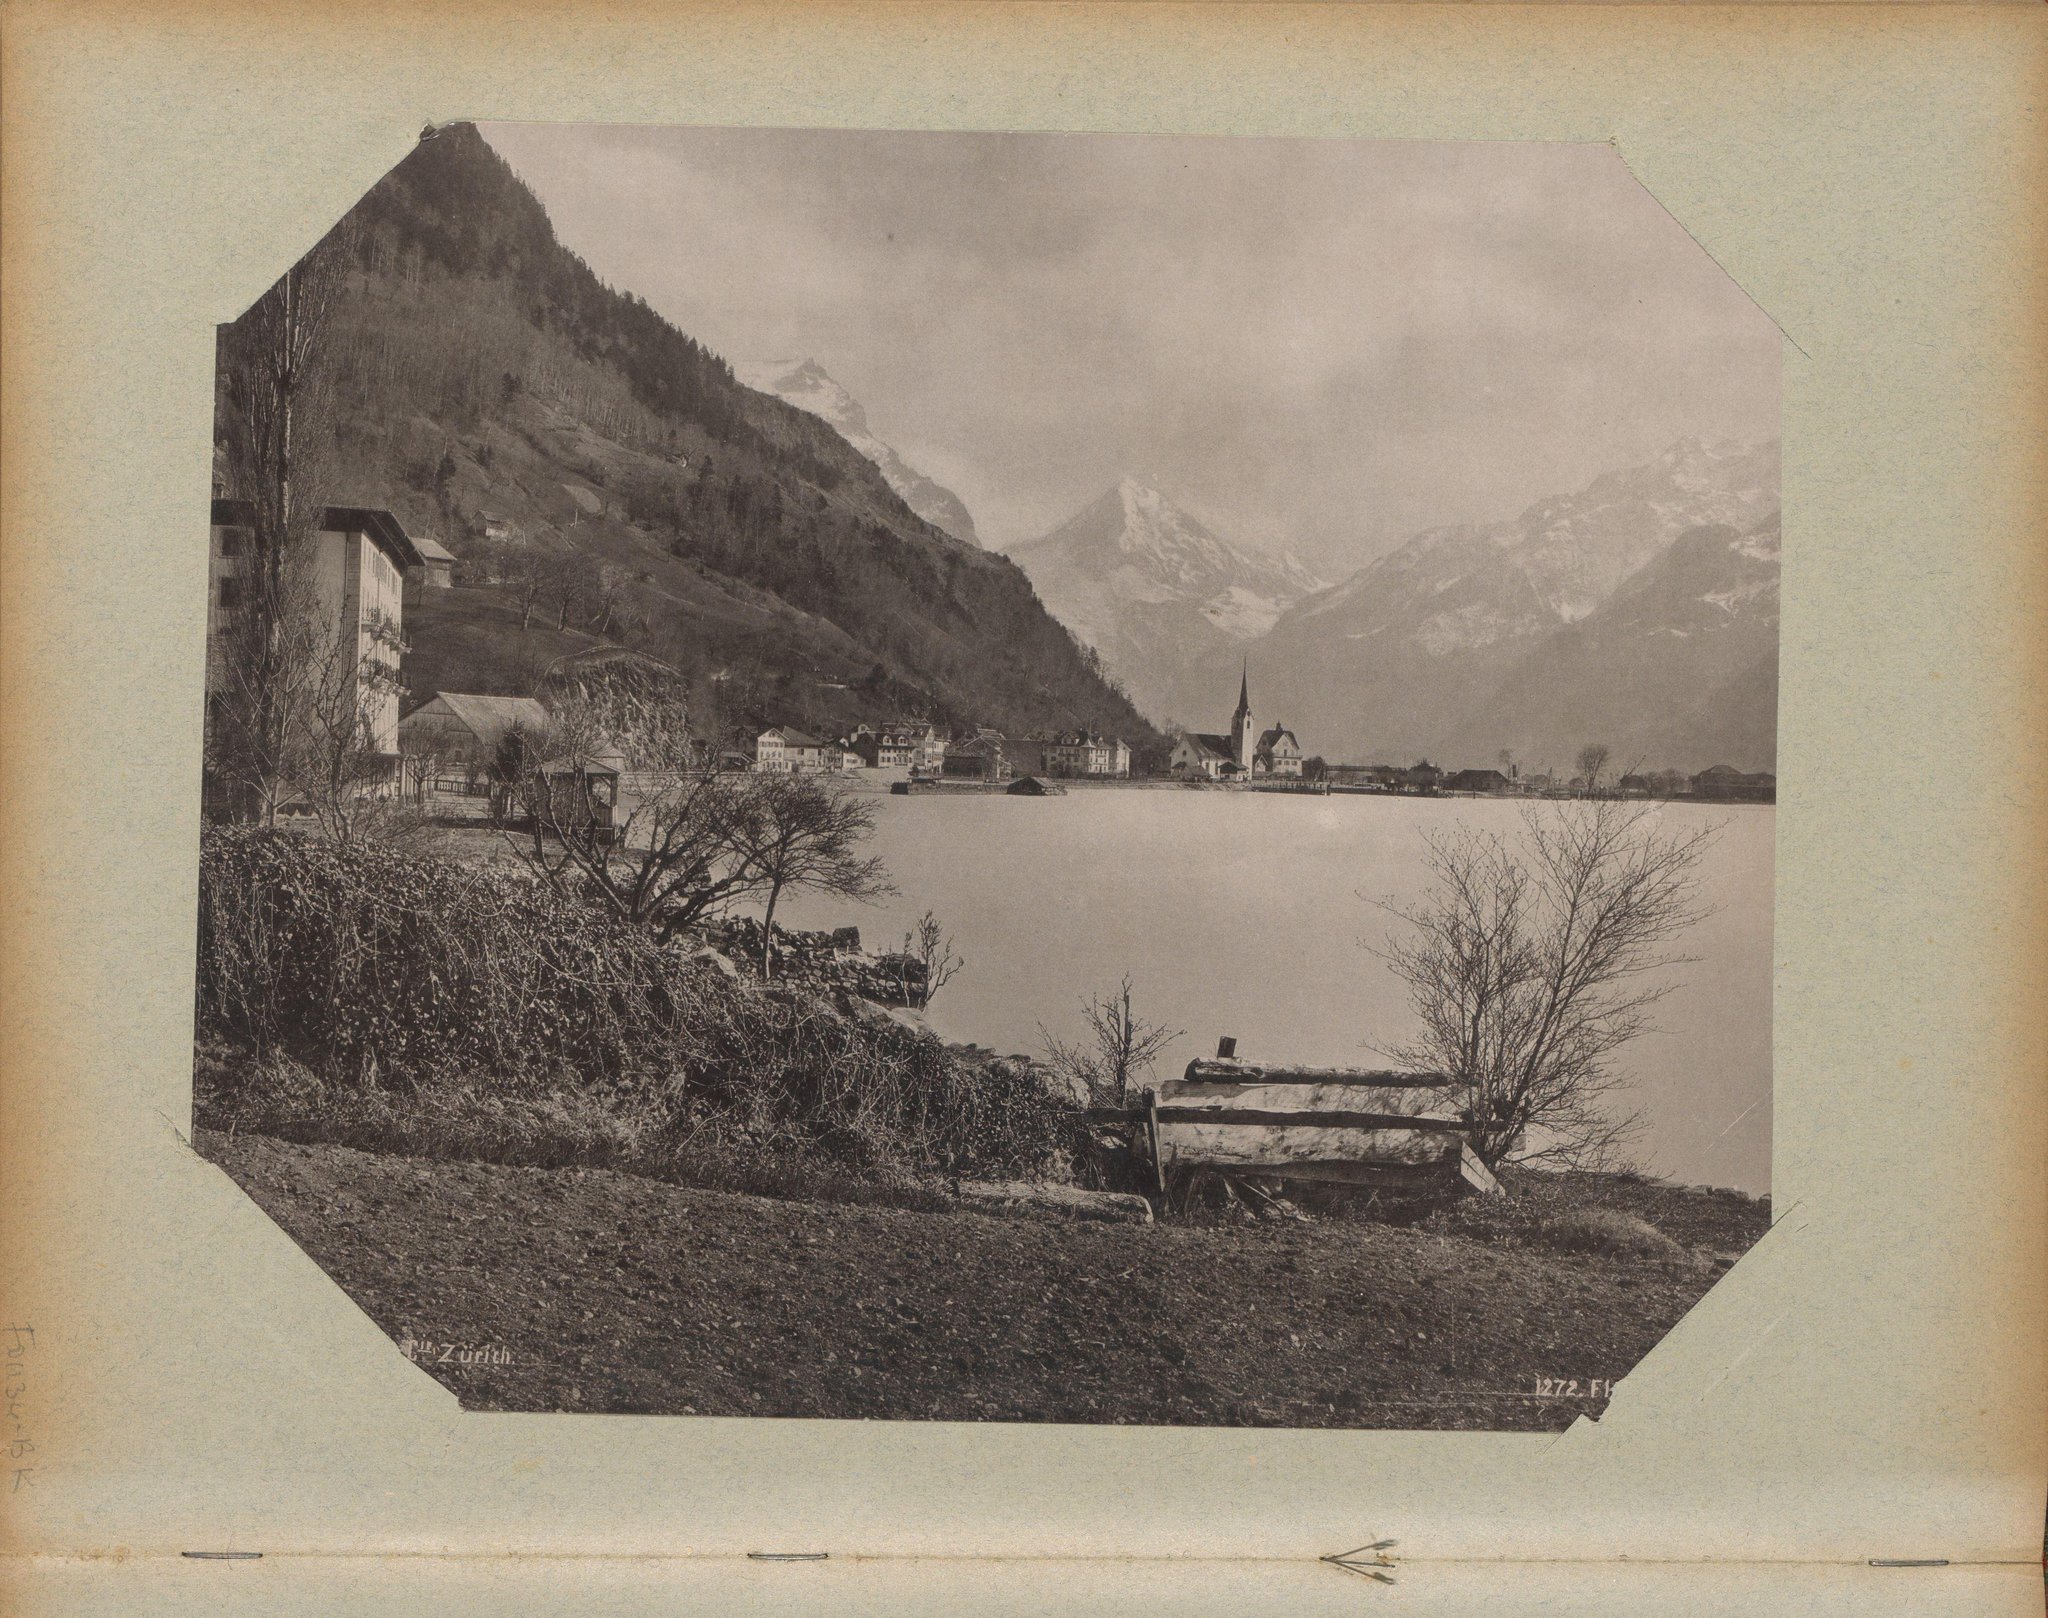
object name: photograph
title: Fluelen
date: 1880-1910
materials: paper, ink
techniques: photograph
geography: flüelen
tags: prospect of village, silhouette of village, mountain-range, snow peaks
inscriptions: number: ‘1272’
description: Onderdeel van Reisalbum met bezienswaardigheden in Engeland, Zwitserland, Frankrijk en Duitsland.